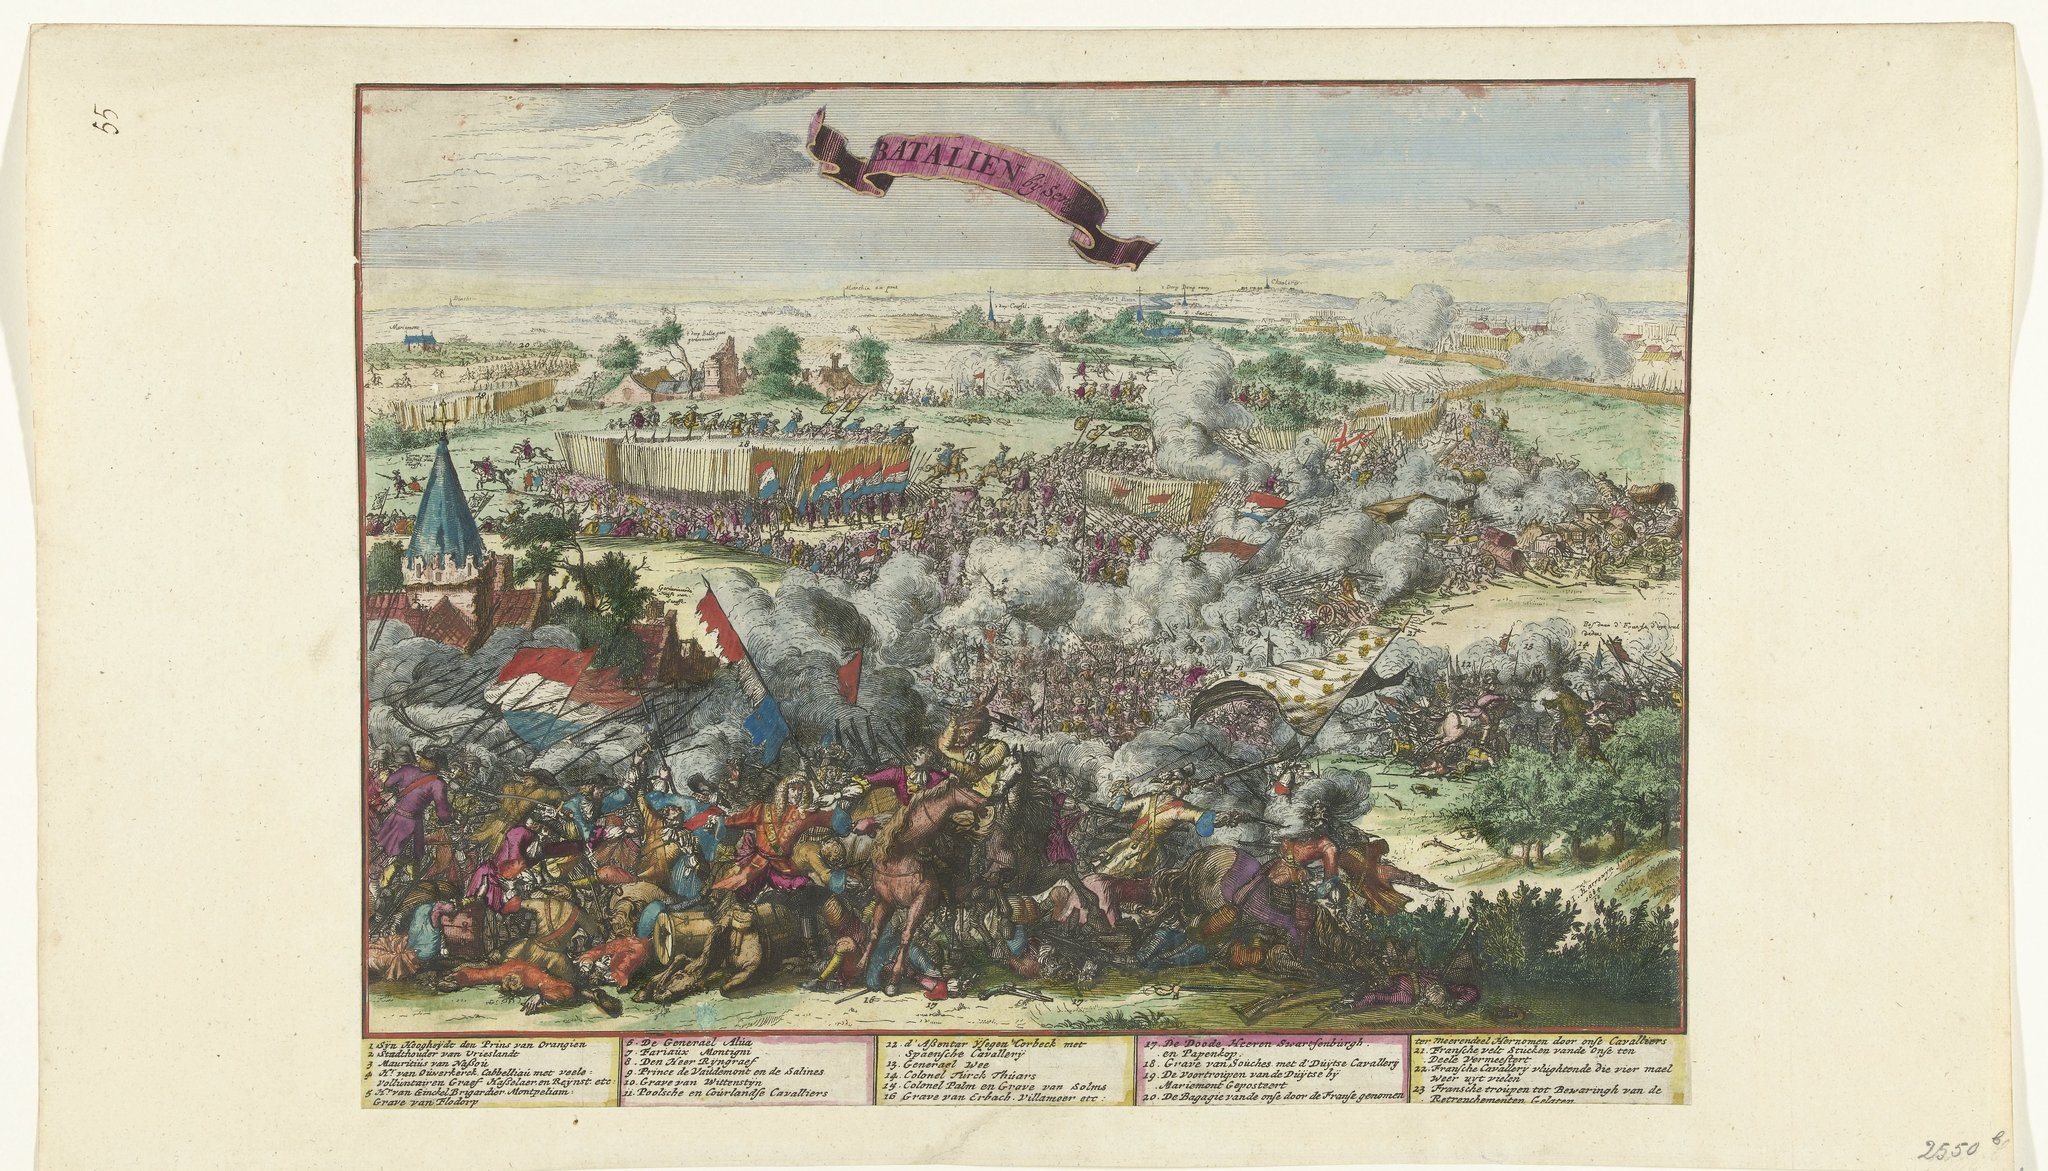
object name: history print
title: Slag bij Seneffe, 1674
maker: jacobus harrewijn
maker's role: print maker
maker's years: 1660-1740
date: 1610-1684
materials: paper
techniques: etching, hand coloring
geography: northern netherlands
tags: william iii (prince of orange and king of england, scotland, and ireland), paris, lodewijk ii de bourbon-condé (hertog van enghien), battle (+ land forces)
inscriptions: date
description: Slag bij Seneffe op 11 juli 1674 tussen de geallieerde Spaanse, Staatse en keizerlijke troepen enerzijds en de Fransen onder de prins van Condé anderzijds. In het onderschrift de legenda 1-23 in het Nederlands.